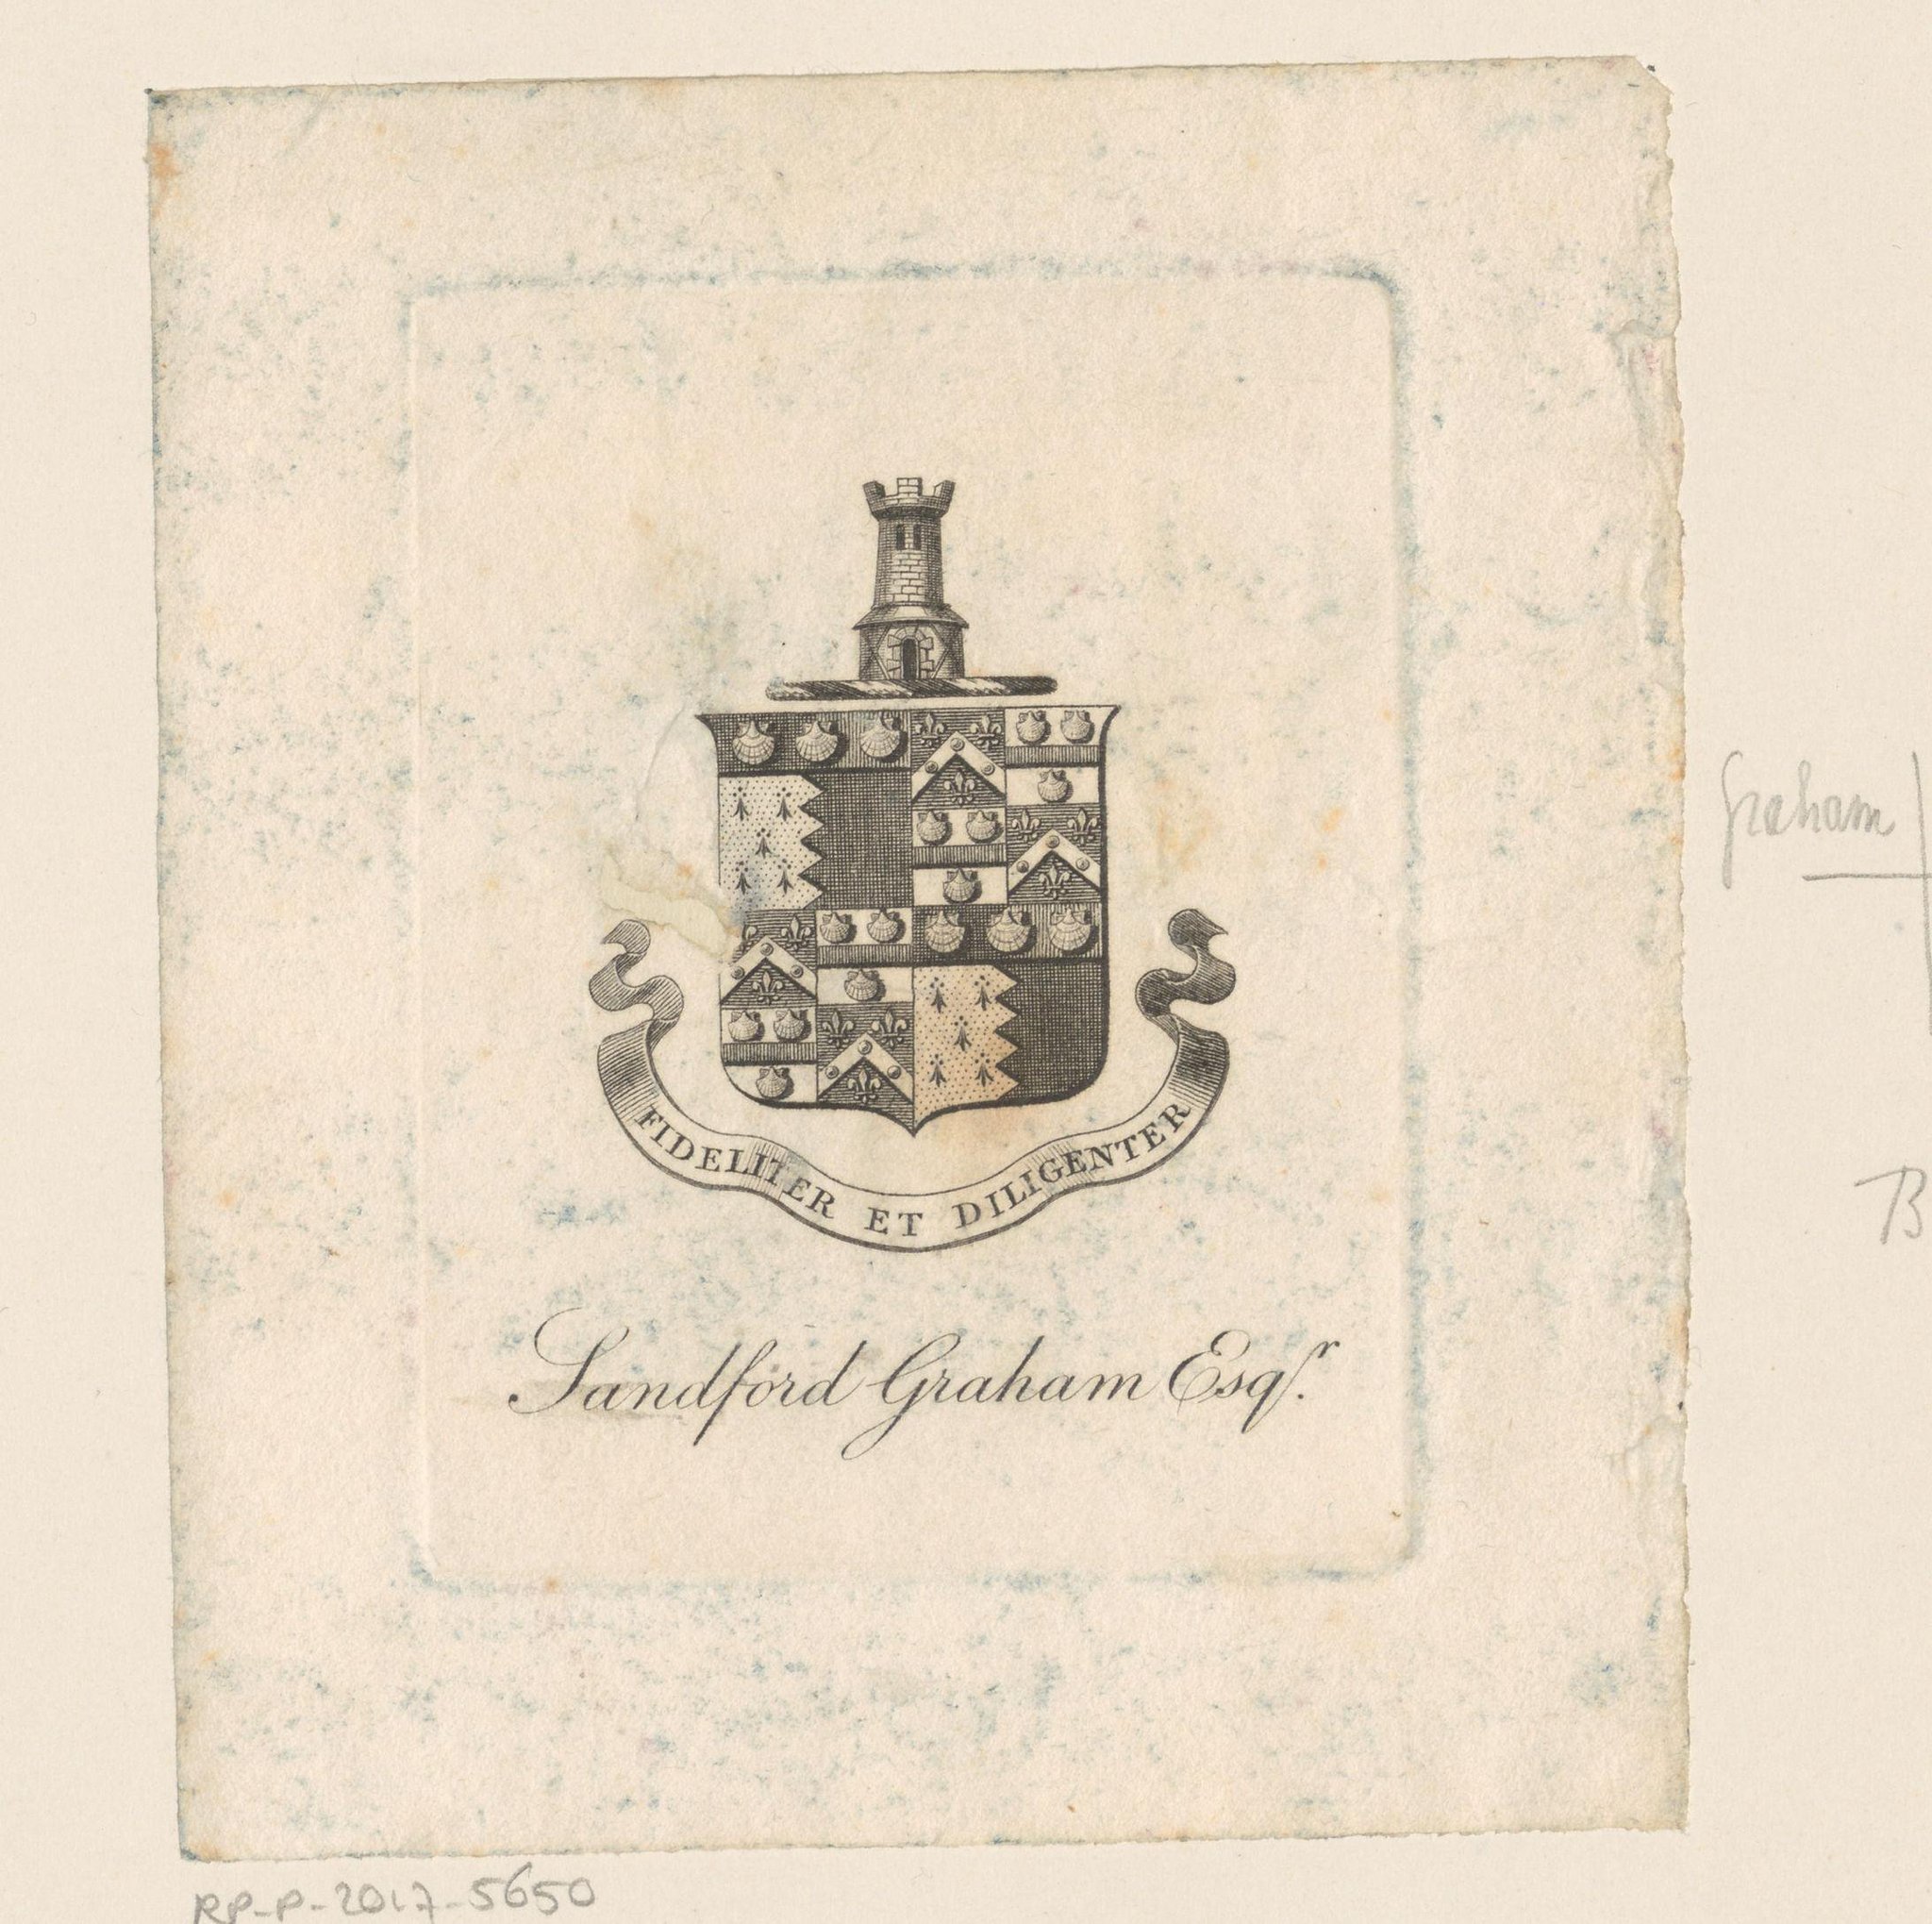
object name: bookplate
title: Ex libris van Sandford Graham Esq.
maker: Anonymous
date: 1750-1849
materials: paper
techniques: etching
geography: england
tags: armorial bearing, heraldry